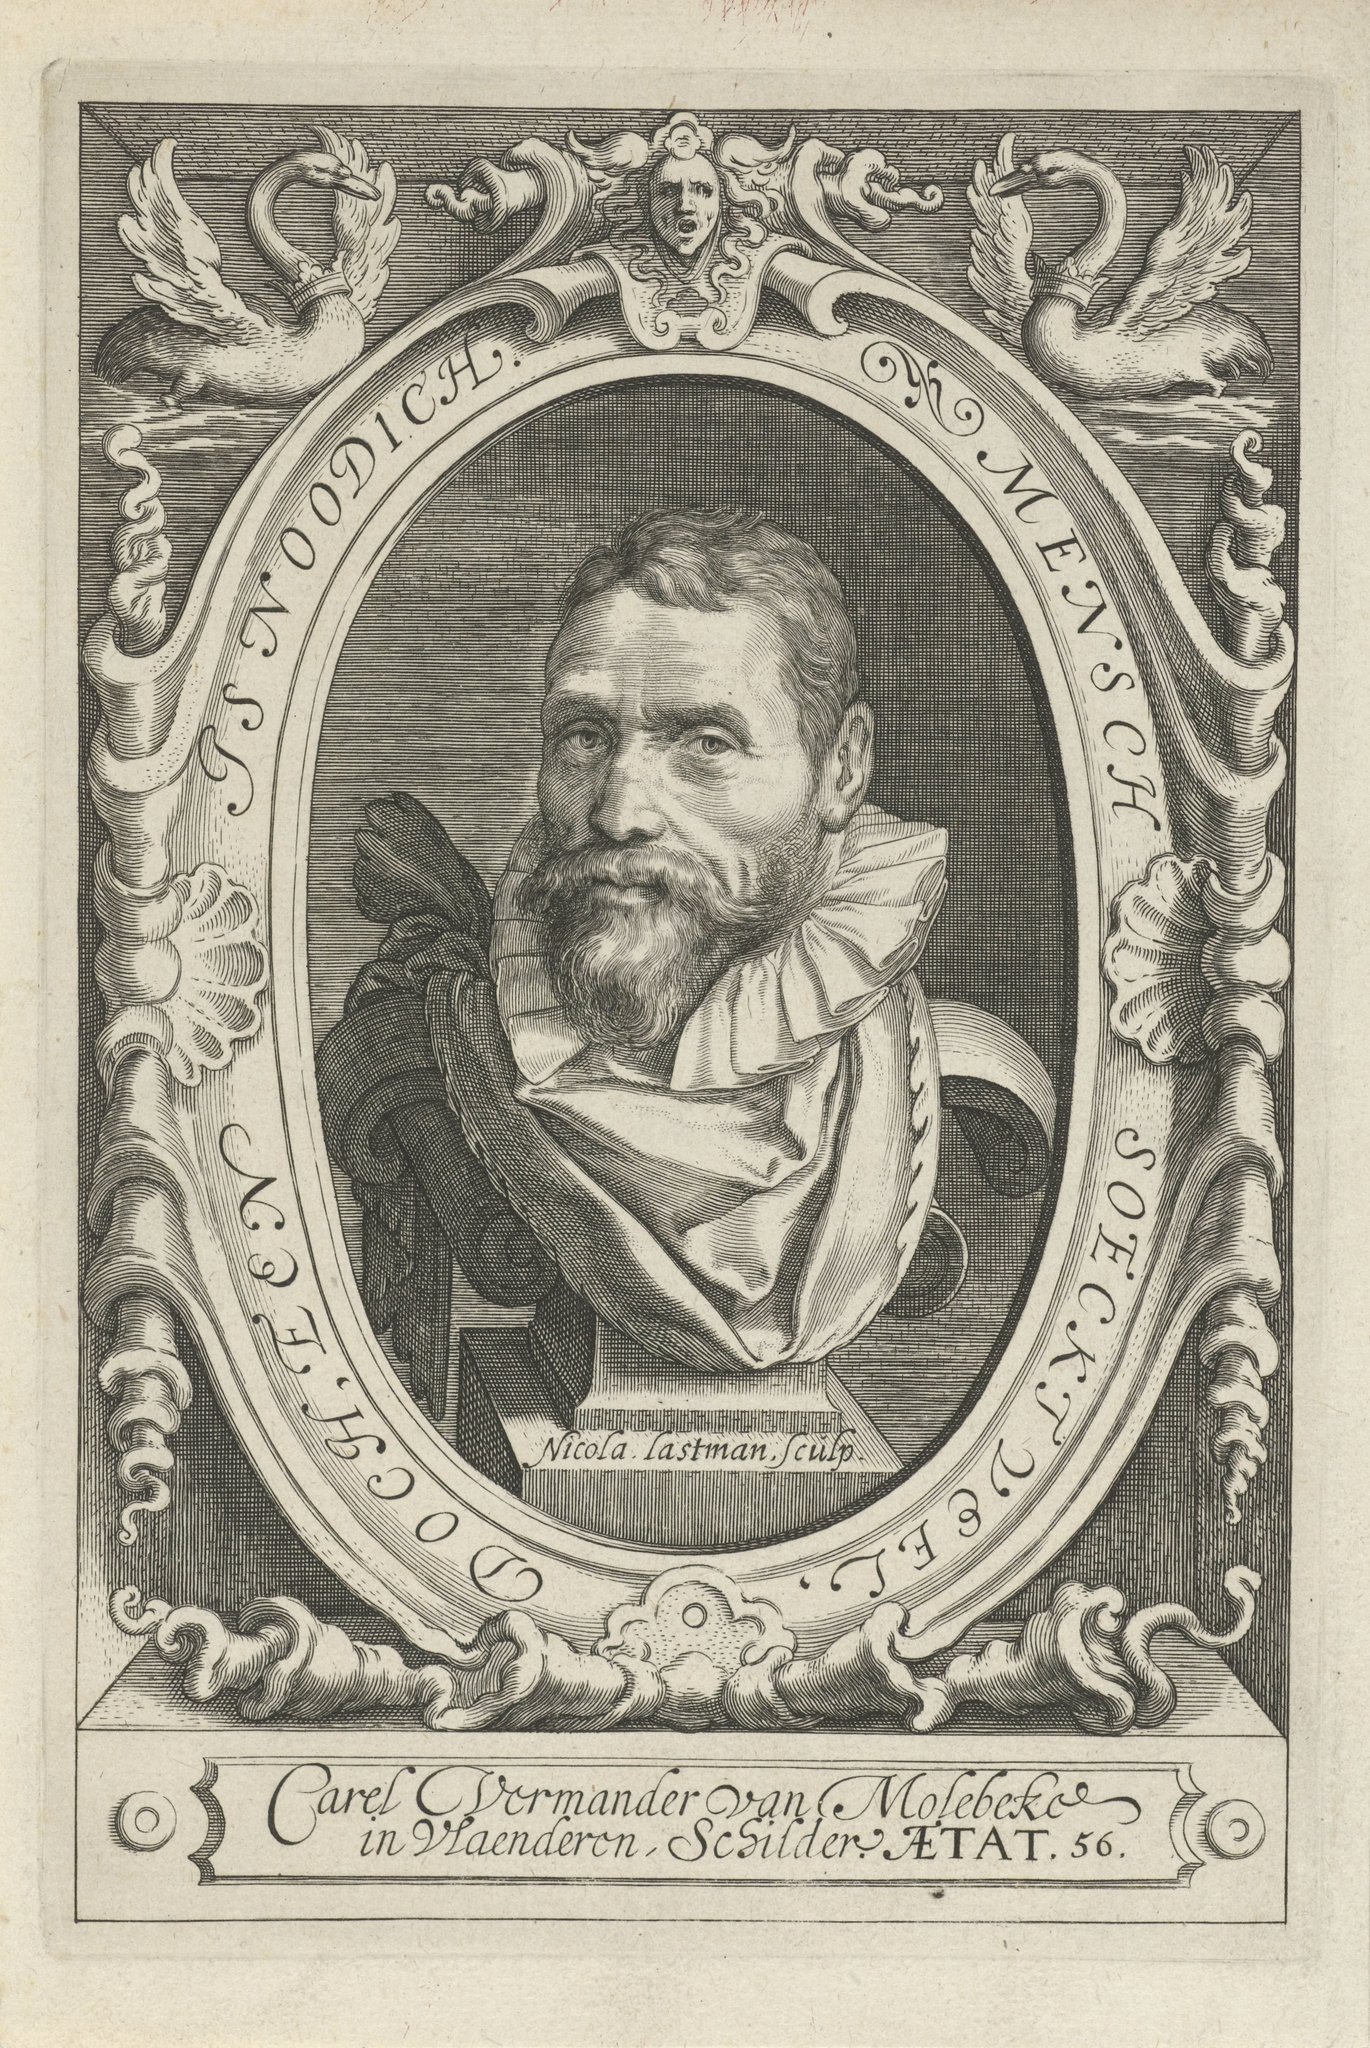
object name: print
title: Portret van Karel van Mander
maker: nicolaes lastman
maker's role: print maker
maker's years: 1586-1625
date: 1604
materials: paper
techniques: engraving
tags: amsterdam, painter, karel van mander (i)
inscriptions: collector's mark: Lugt 2228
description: Borstbeeld op een voetstuk van de kunstschilder en schrijver Karel van Mander. Het borstbeeld is gevat in een cartouchevormige omlijsting met randschrift in het Nederlands. Onder het portret prijkt een plaquette met de naam en leeftijd van de geportretteerde.